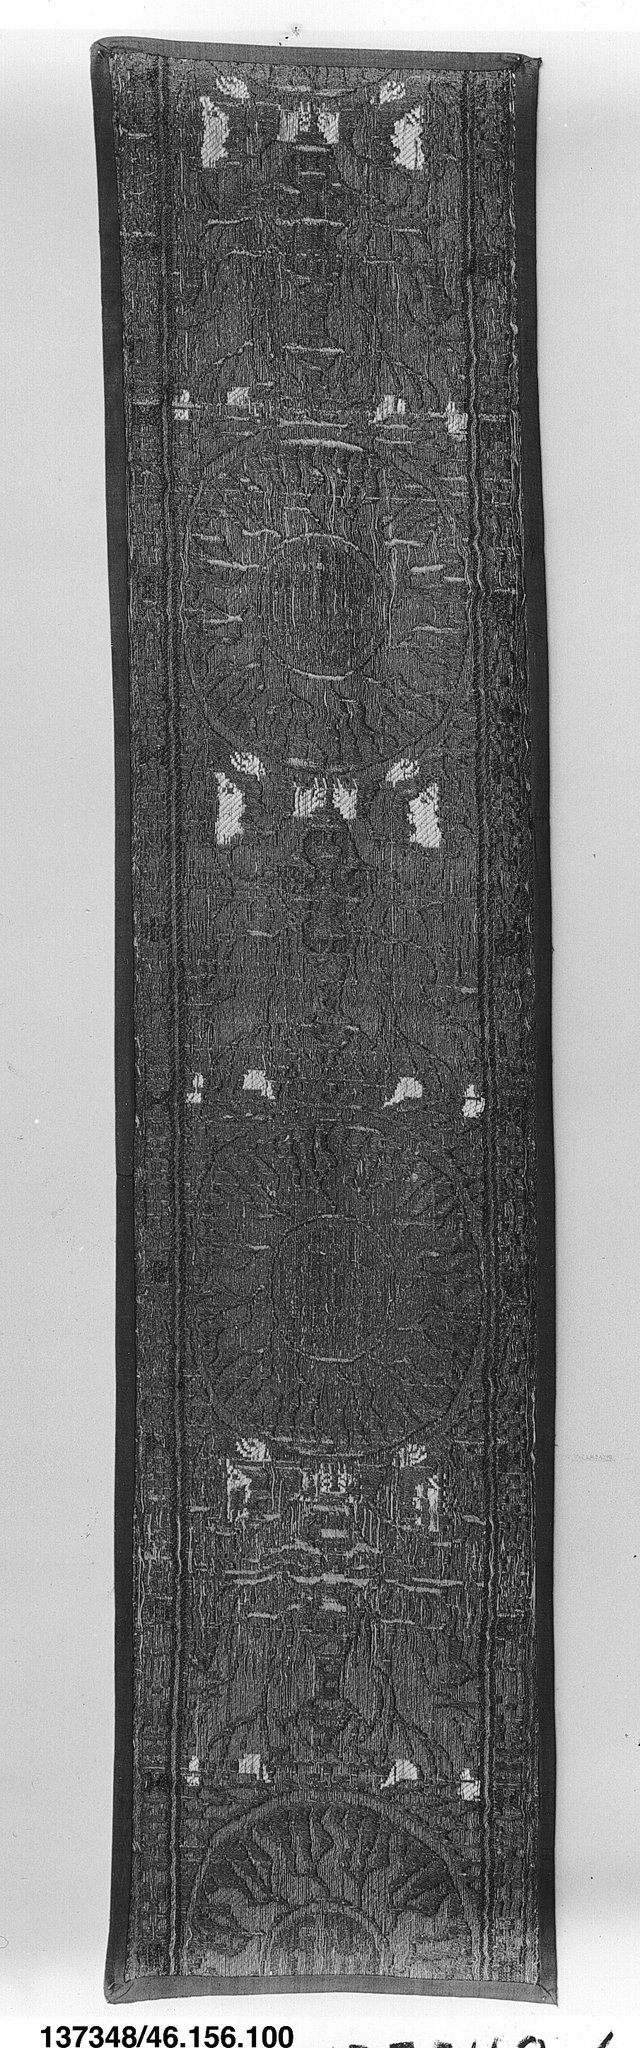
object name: piece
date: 1500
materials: metal thread, silk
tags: human figures